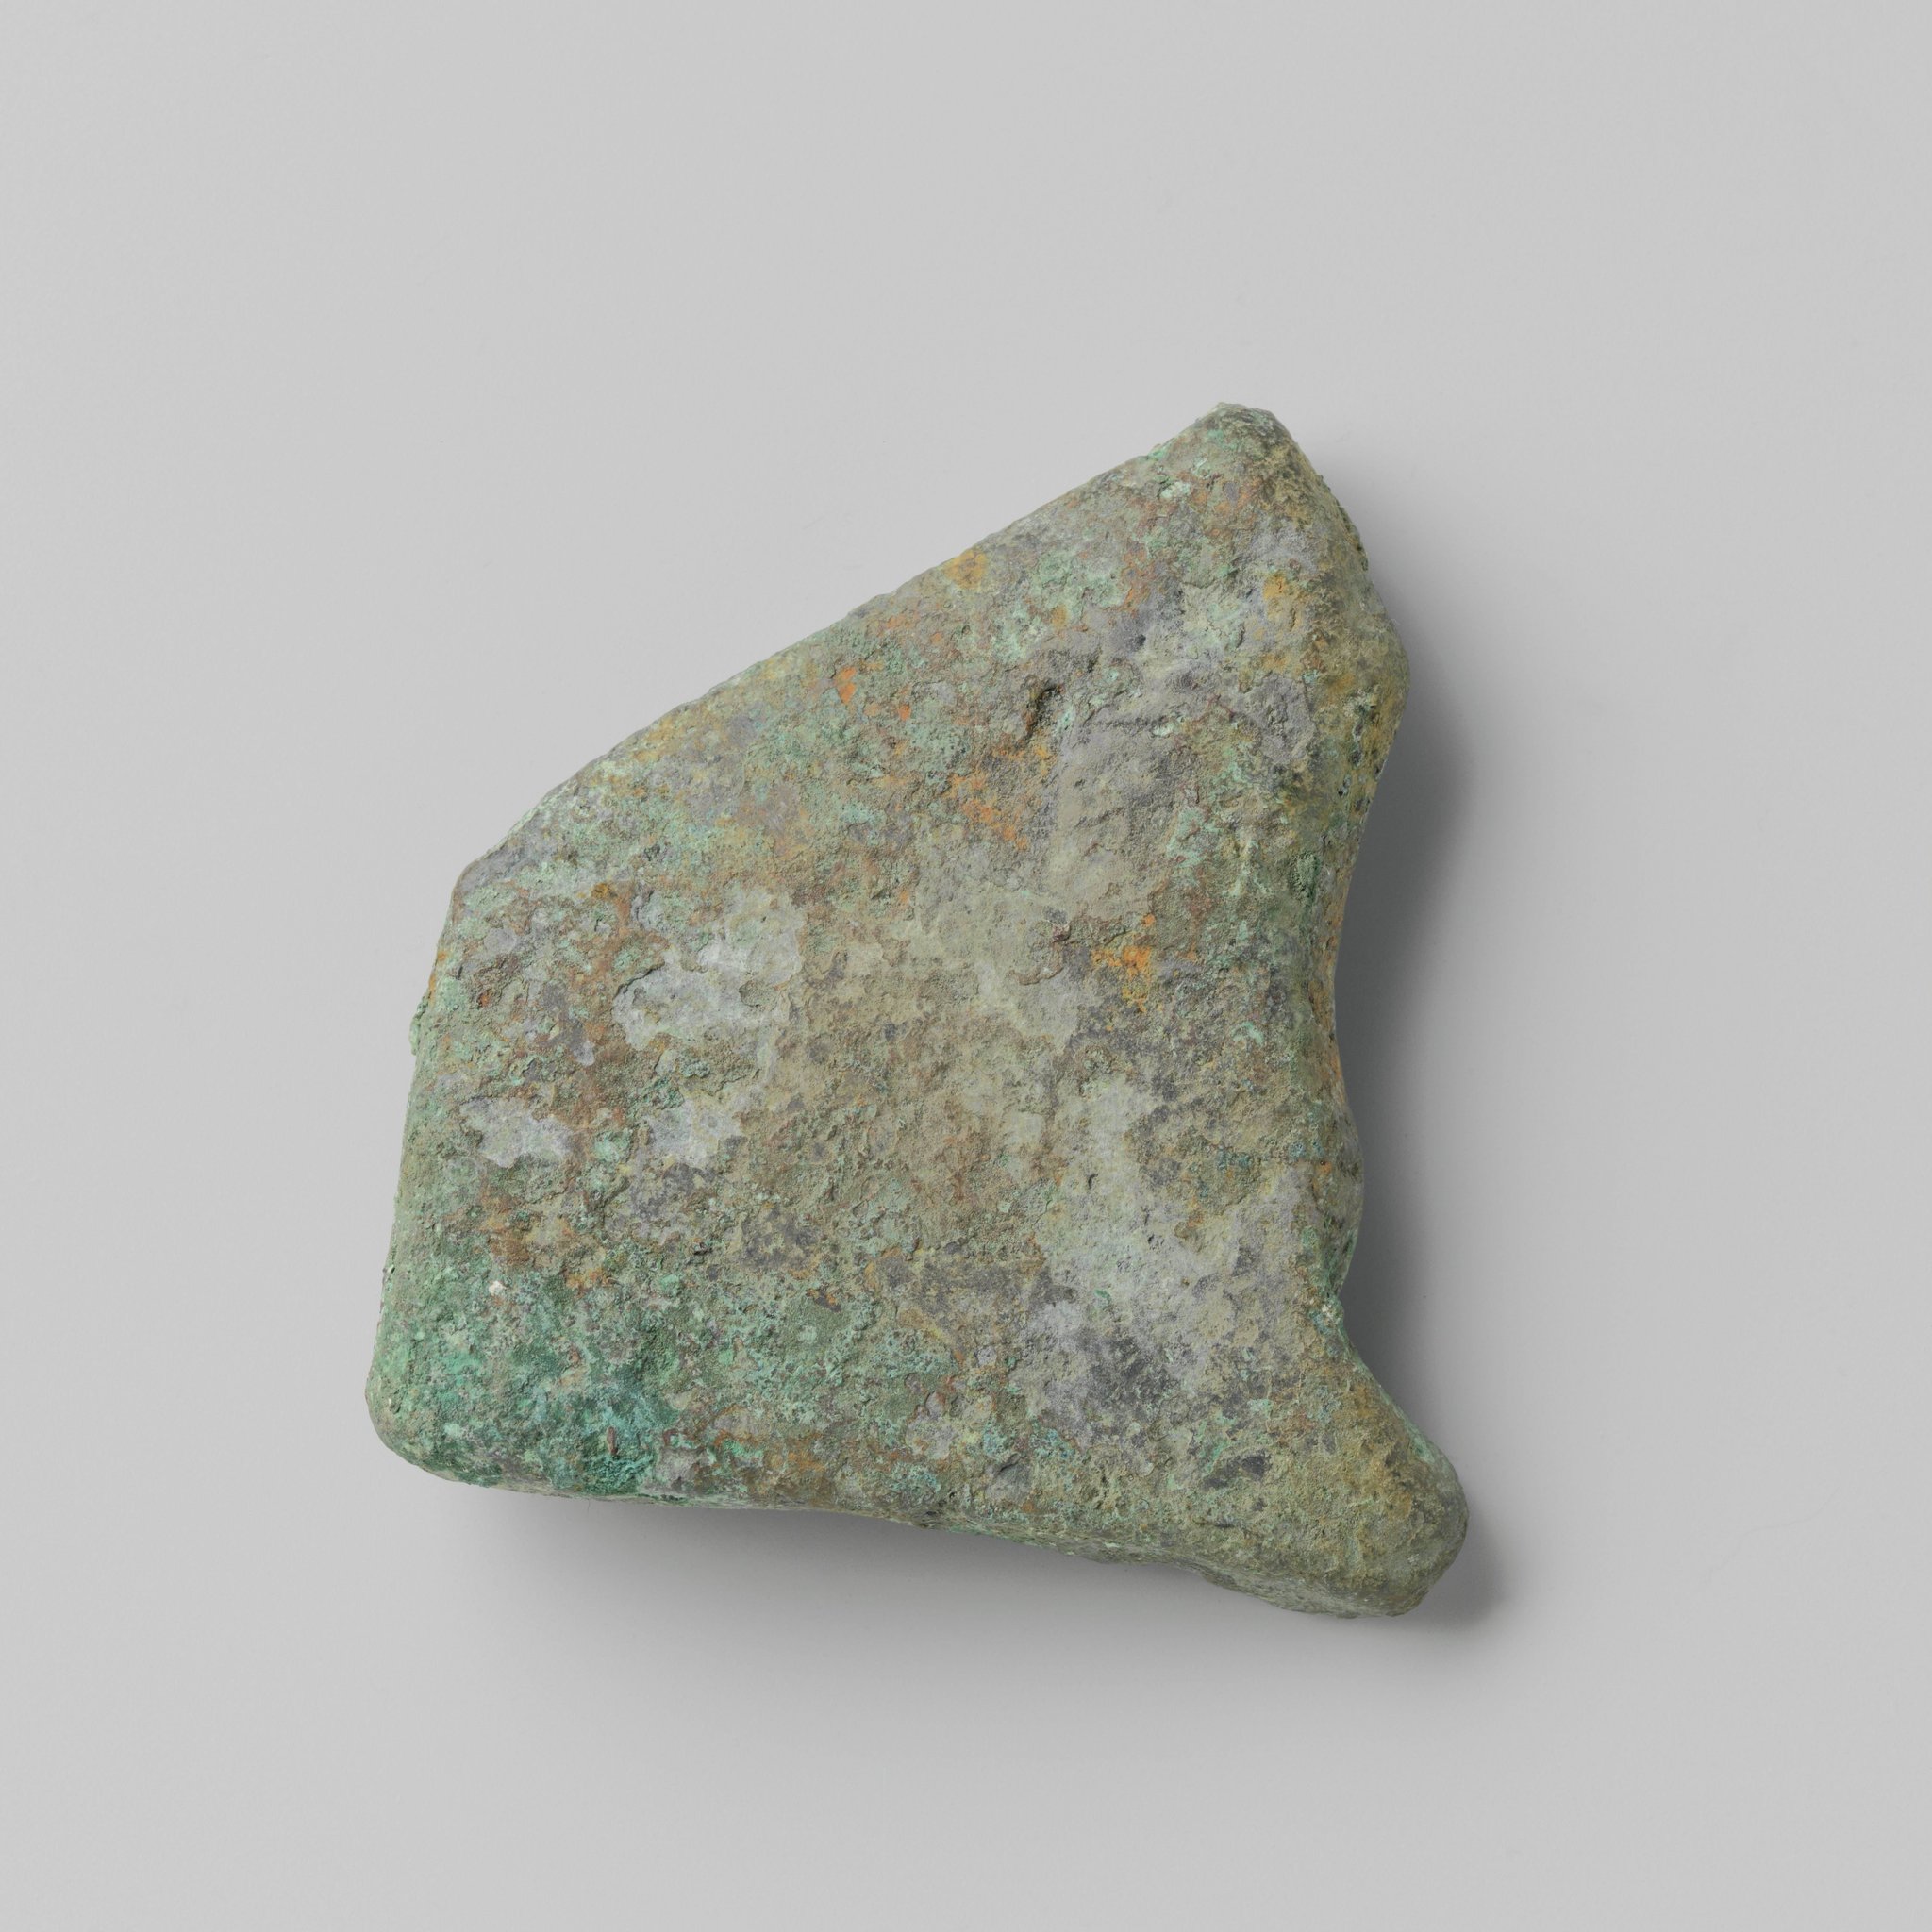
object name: fragment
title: Fragment of a ship bell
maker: Anonymous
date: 1700-1743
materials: copper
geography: netherlands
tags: verenigde oostindische compagnie, hollandia (schip), annet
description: Acoustic, bell (ship's); fragment, sim. NG 1980-27H2954.